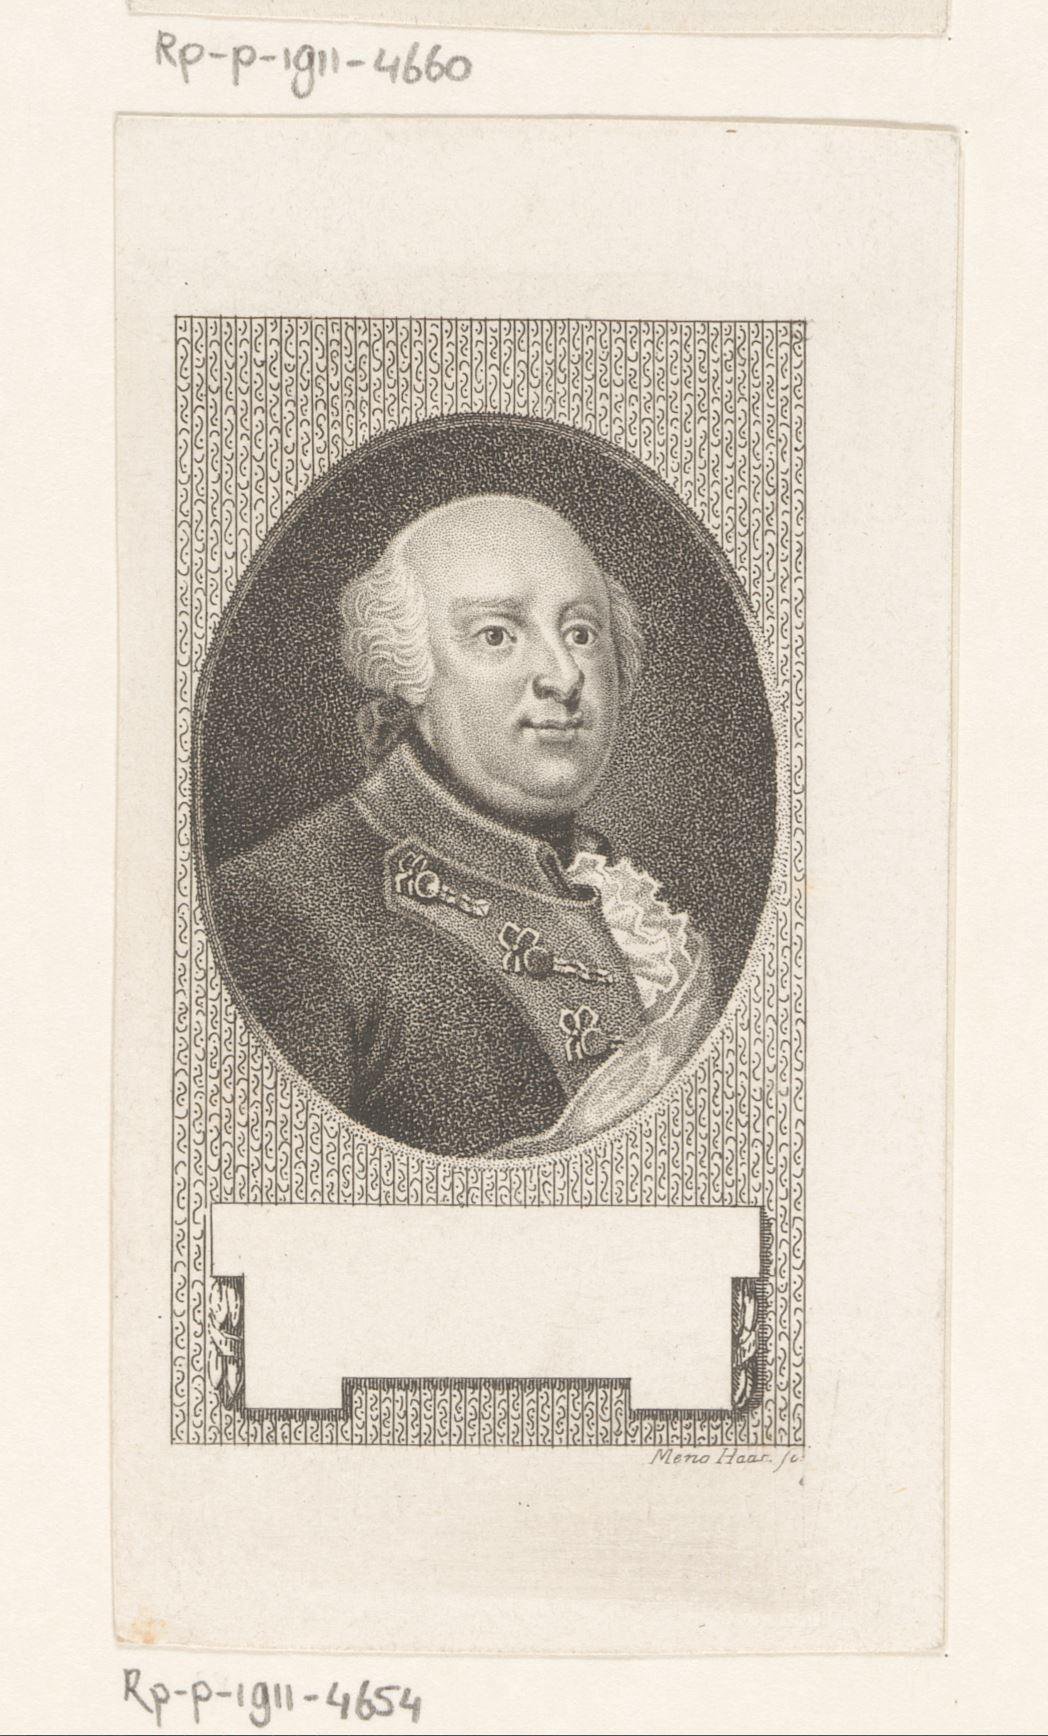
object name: print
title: Portret van Frederik Willem II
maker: meno haas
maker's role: print maker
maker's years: 1752-1833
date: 1762-1797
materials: paper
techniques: etching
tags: berlin, frederik willem ii (koning van pruisen), historical persons, ruler, sovereign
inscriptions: collector's mark: Lugt 2228